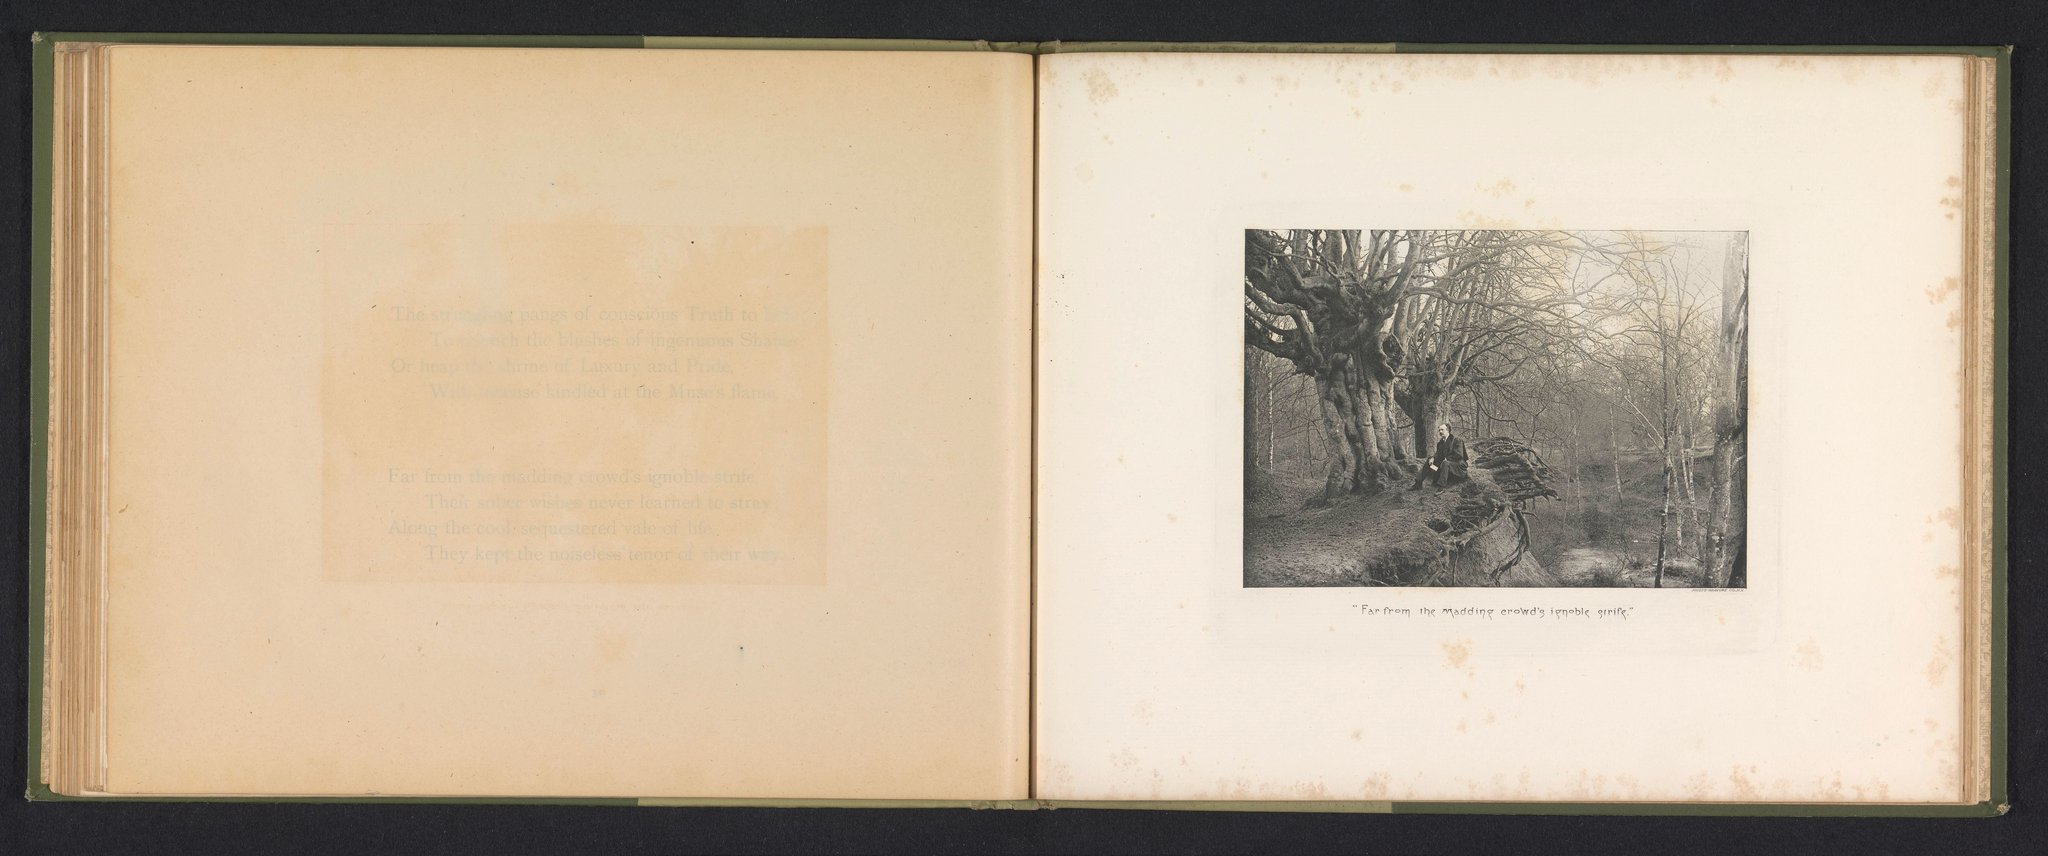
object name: photomechanical print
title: Far from the madding crowd's ignoble strife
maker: james leon williams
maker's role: fotograaf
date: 1881-1891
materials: paper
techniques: photoaquatint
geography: england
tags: trees, adult man, england